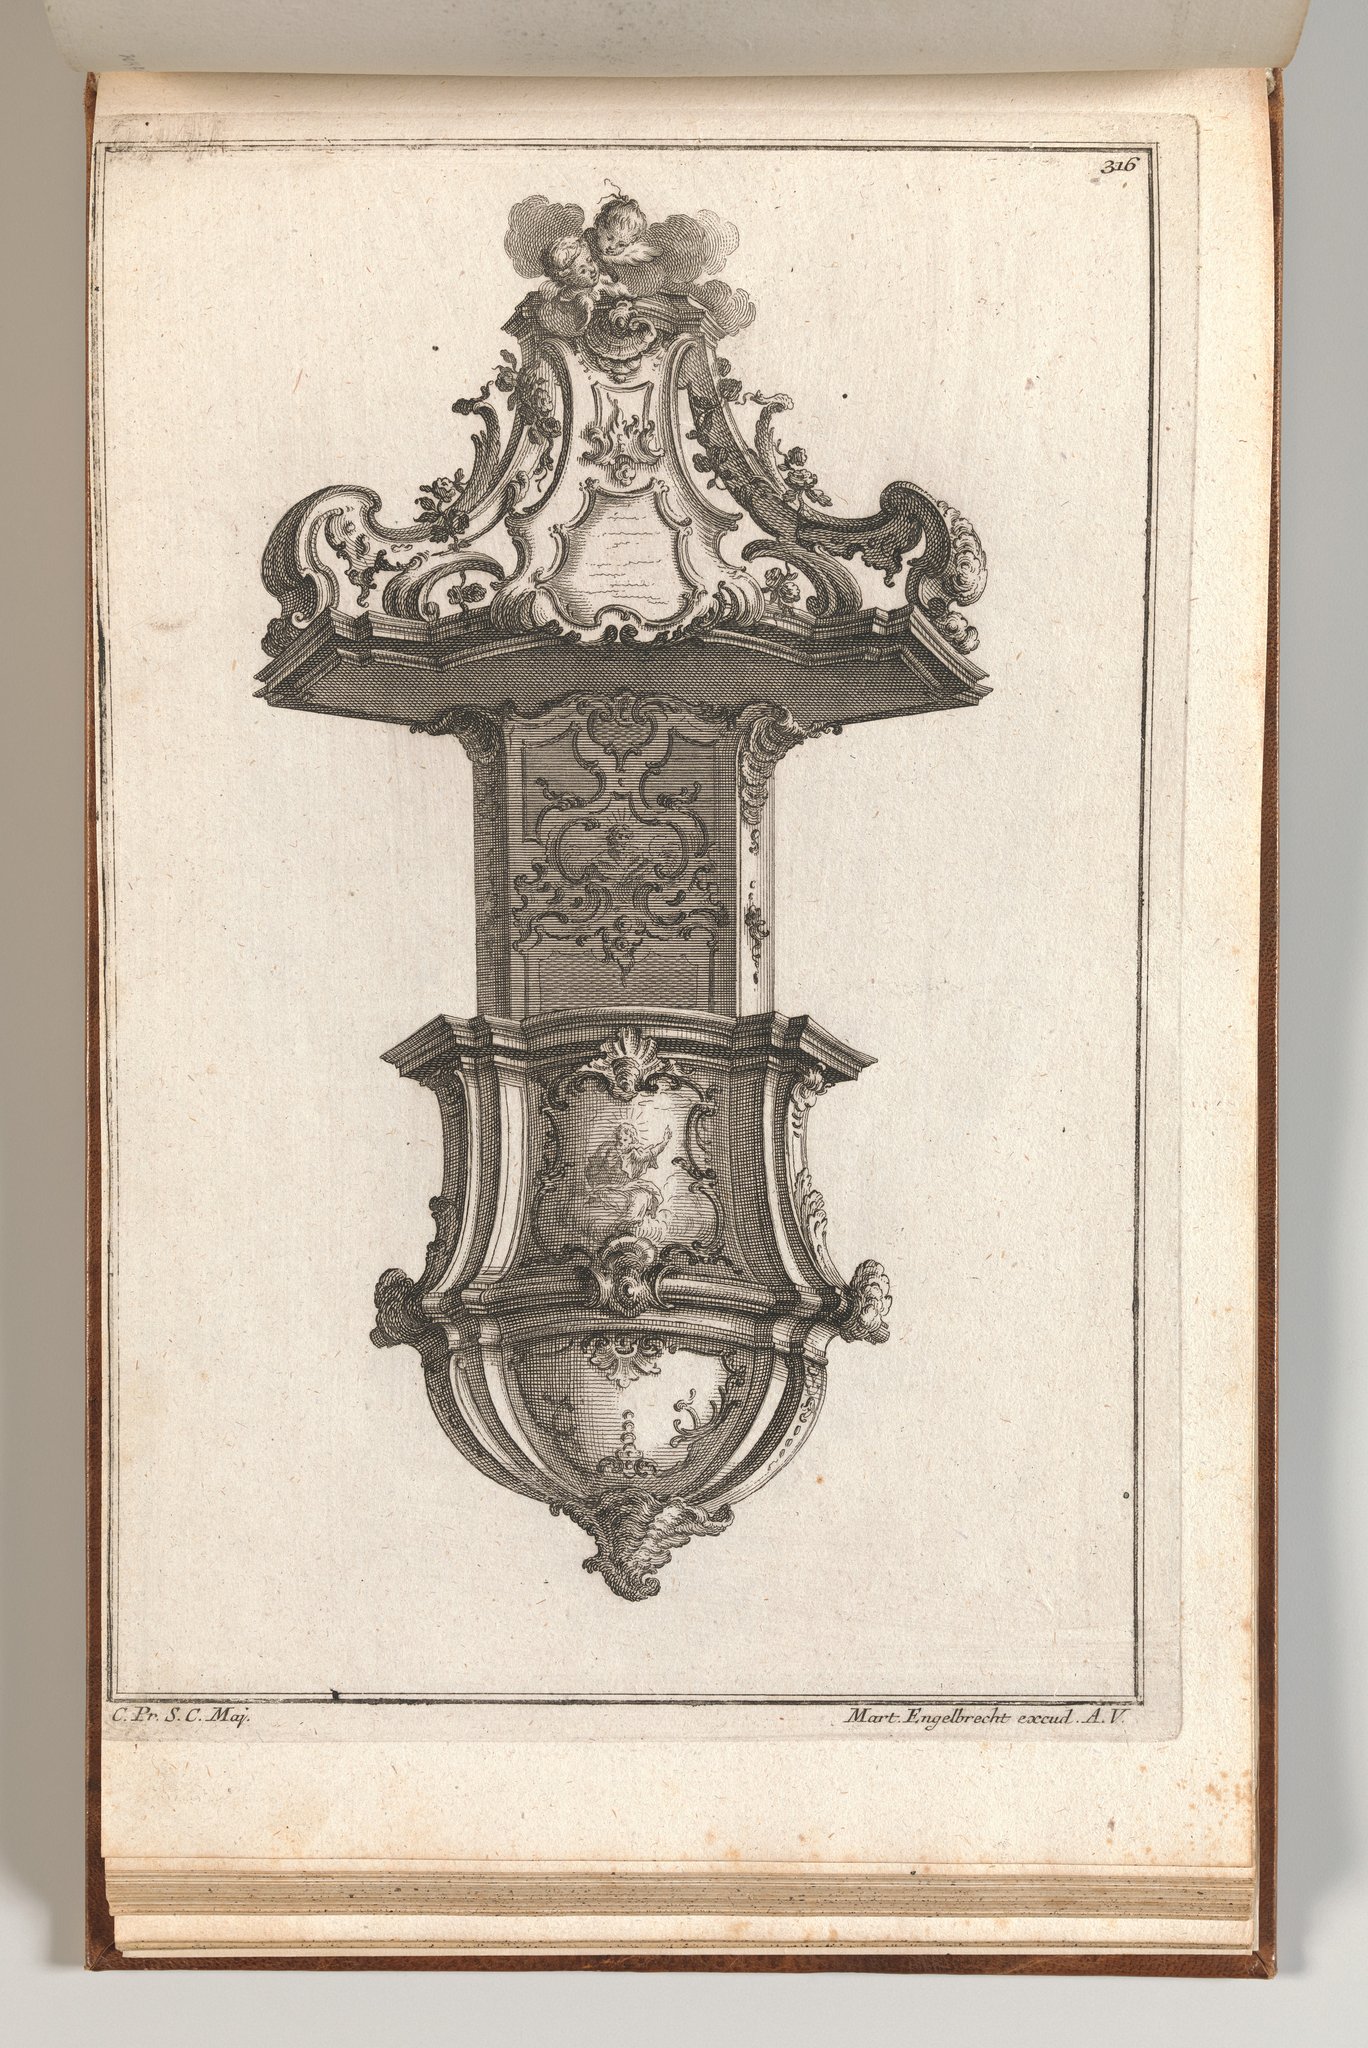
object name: album print ornament architecture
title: Design for a Pulpit, Plate 3 from an Untitled Series of Pulpit Designs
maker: martin engelbrecht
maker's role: publisher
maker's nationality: german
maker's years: 1684-1756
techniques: etching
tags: ornament